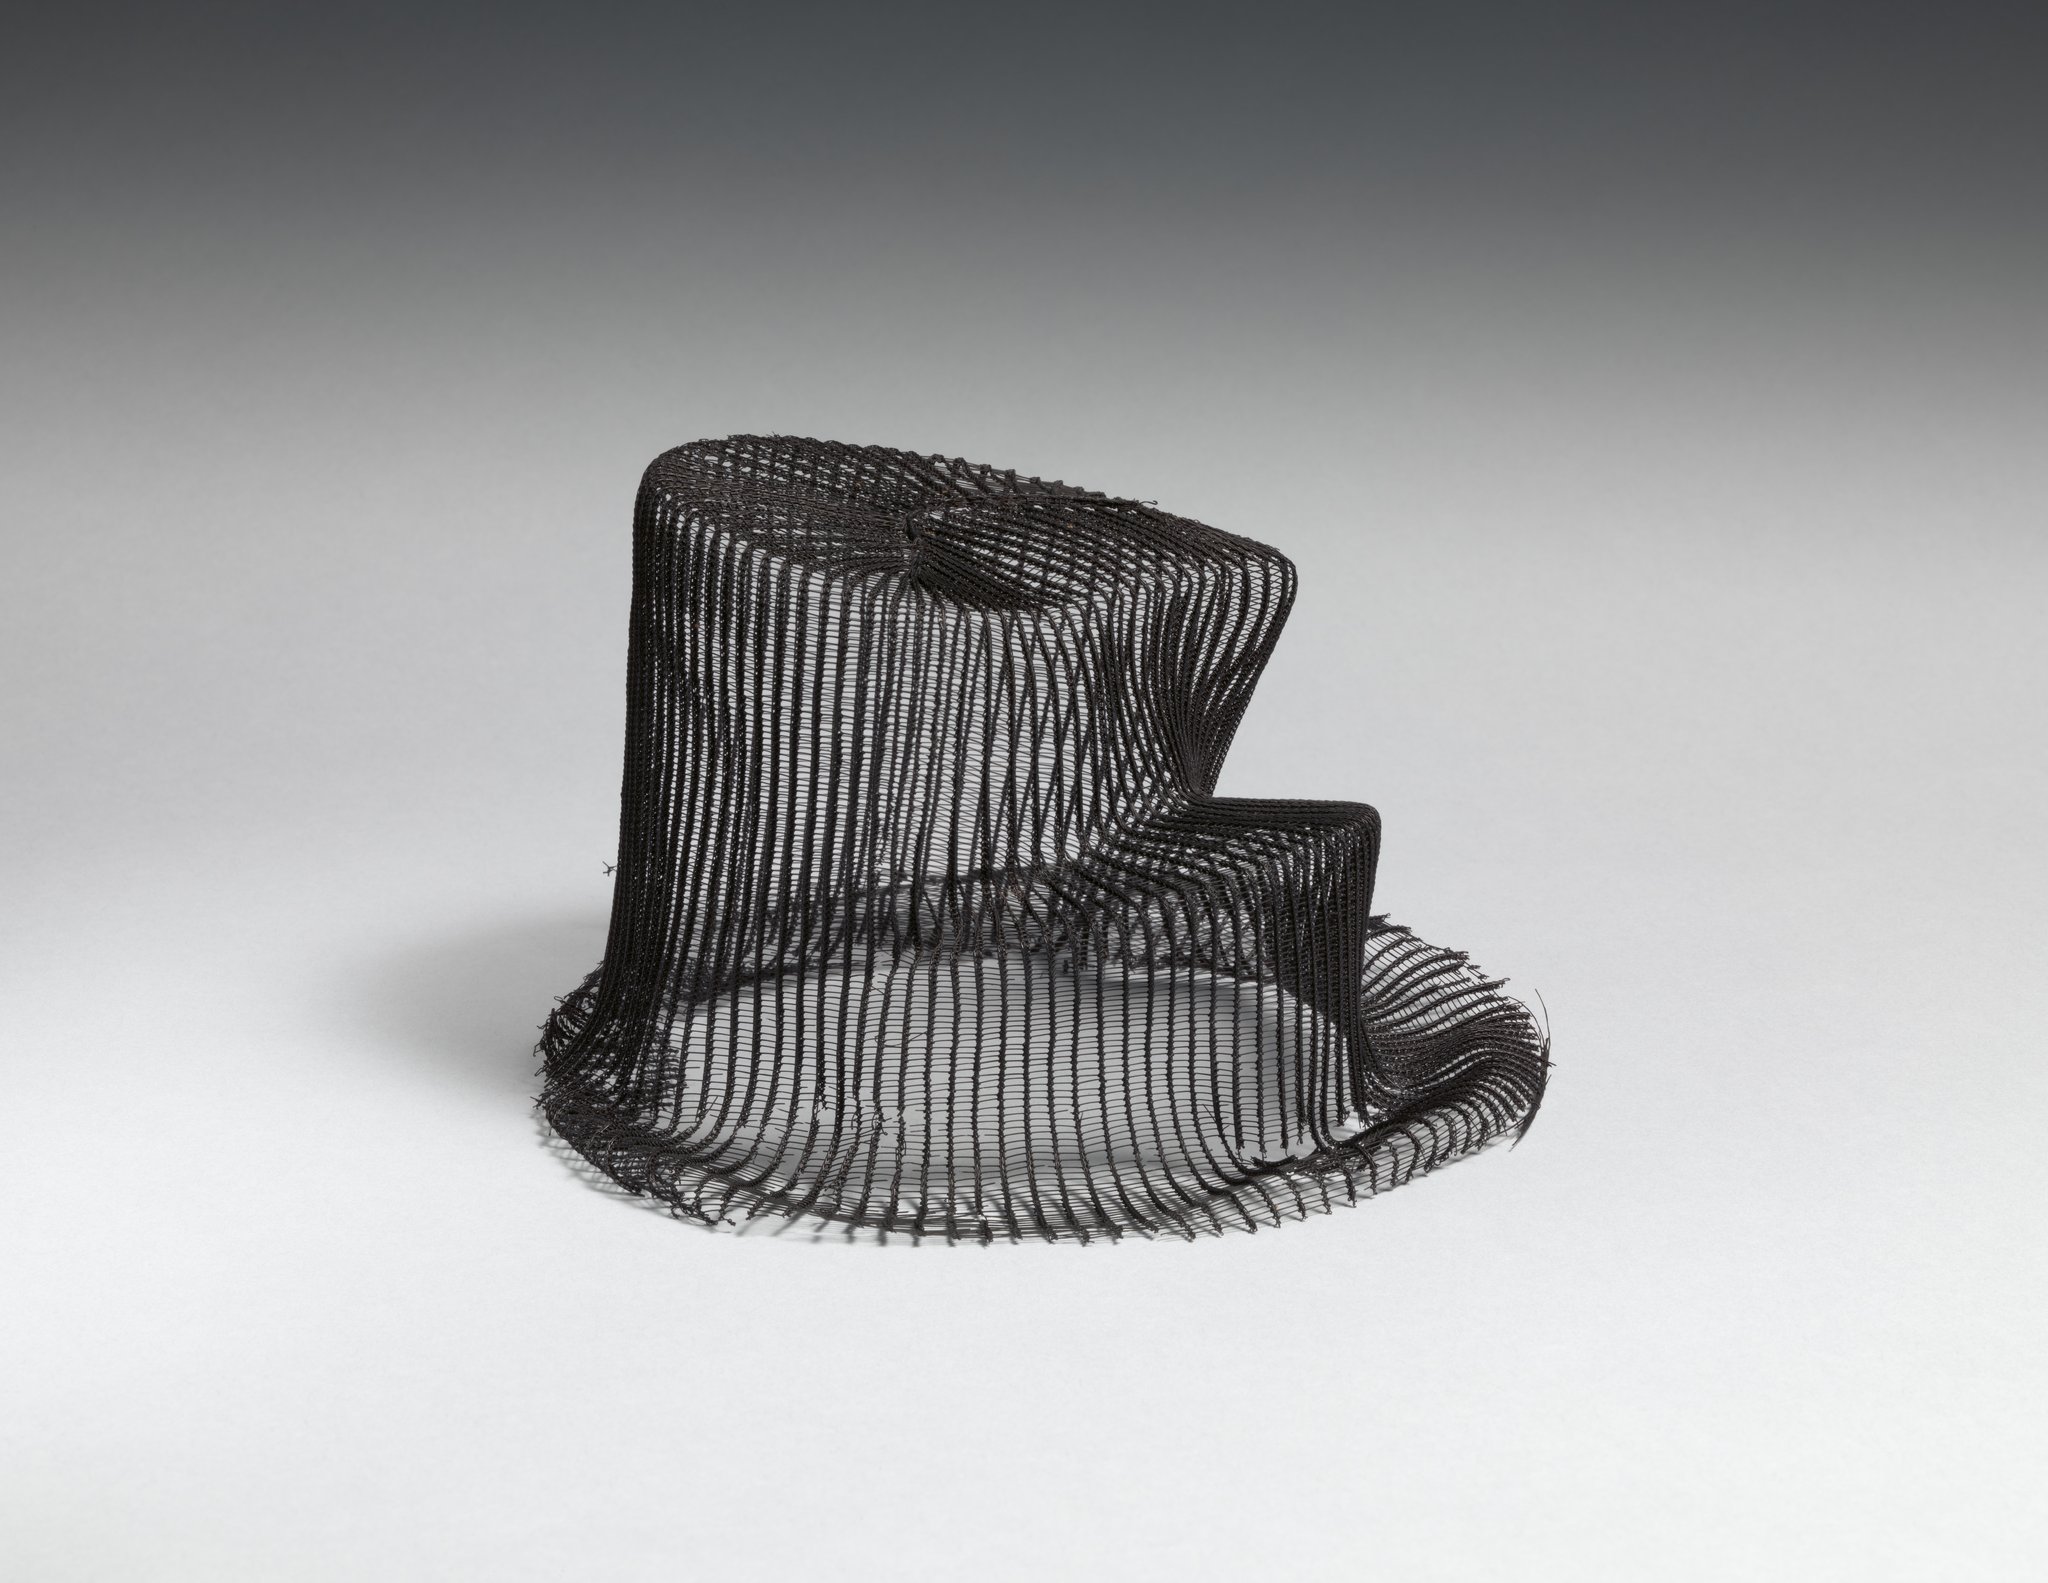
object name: man's inner hat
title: Man's inner hat (Tanggeon)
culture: korean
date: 1801-1900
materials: hair